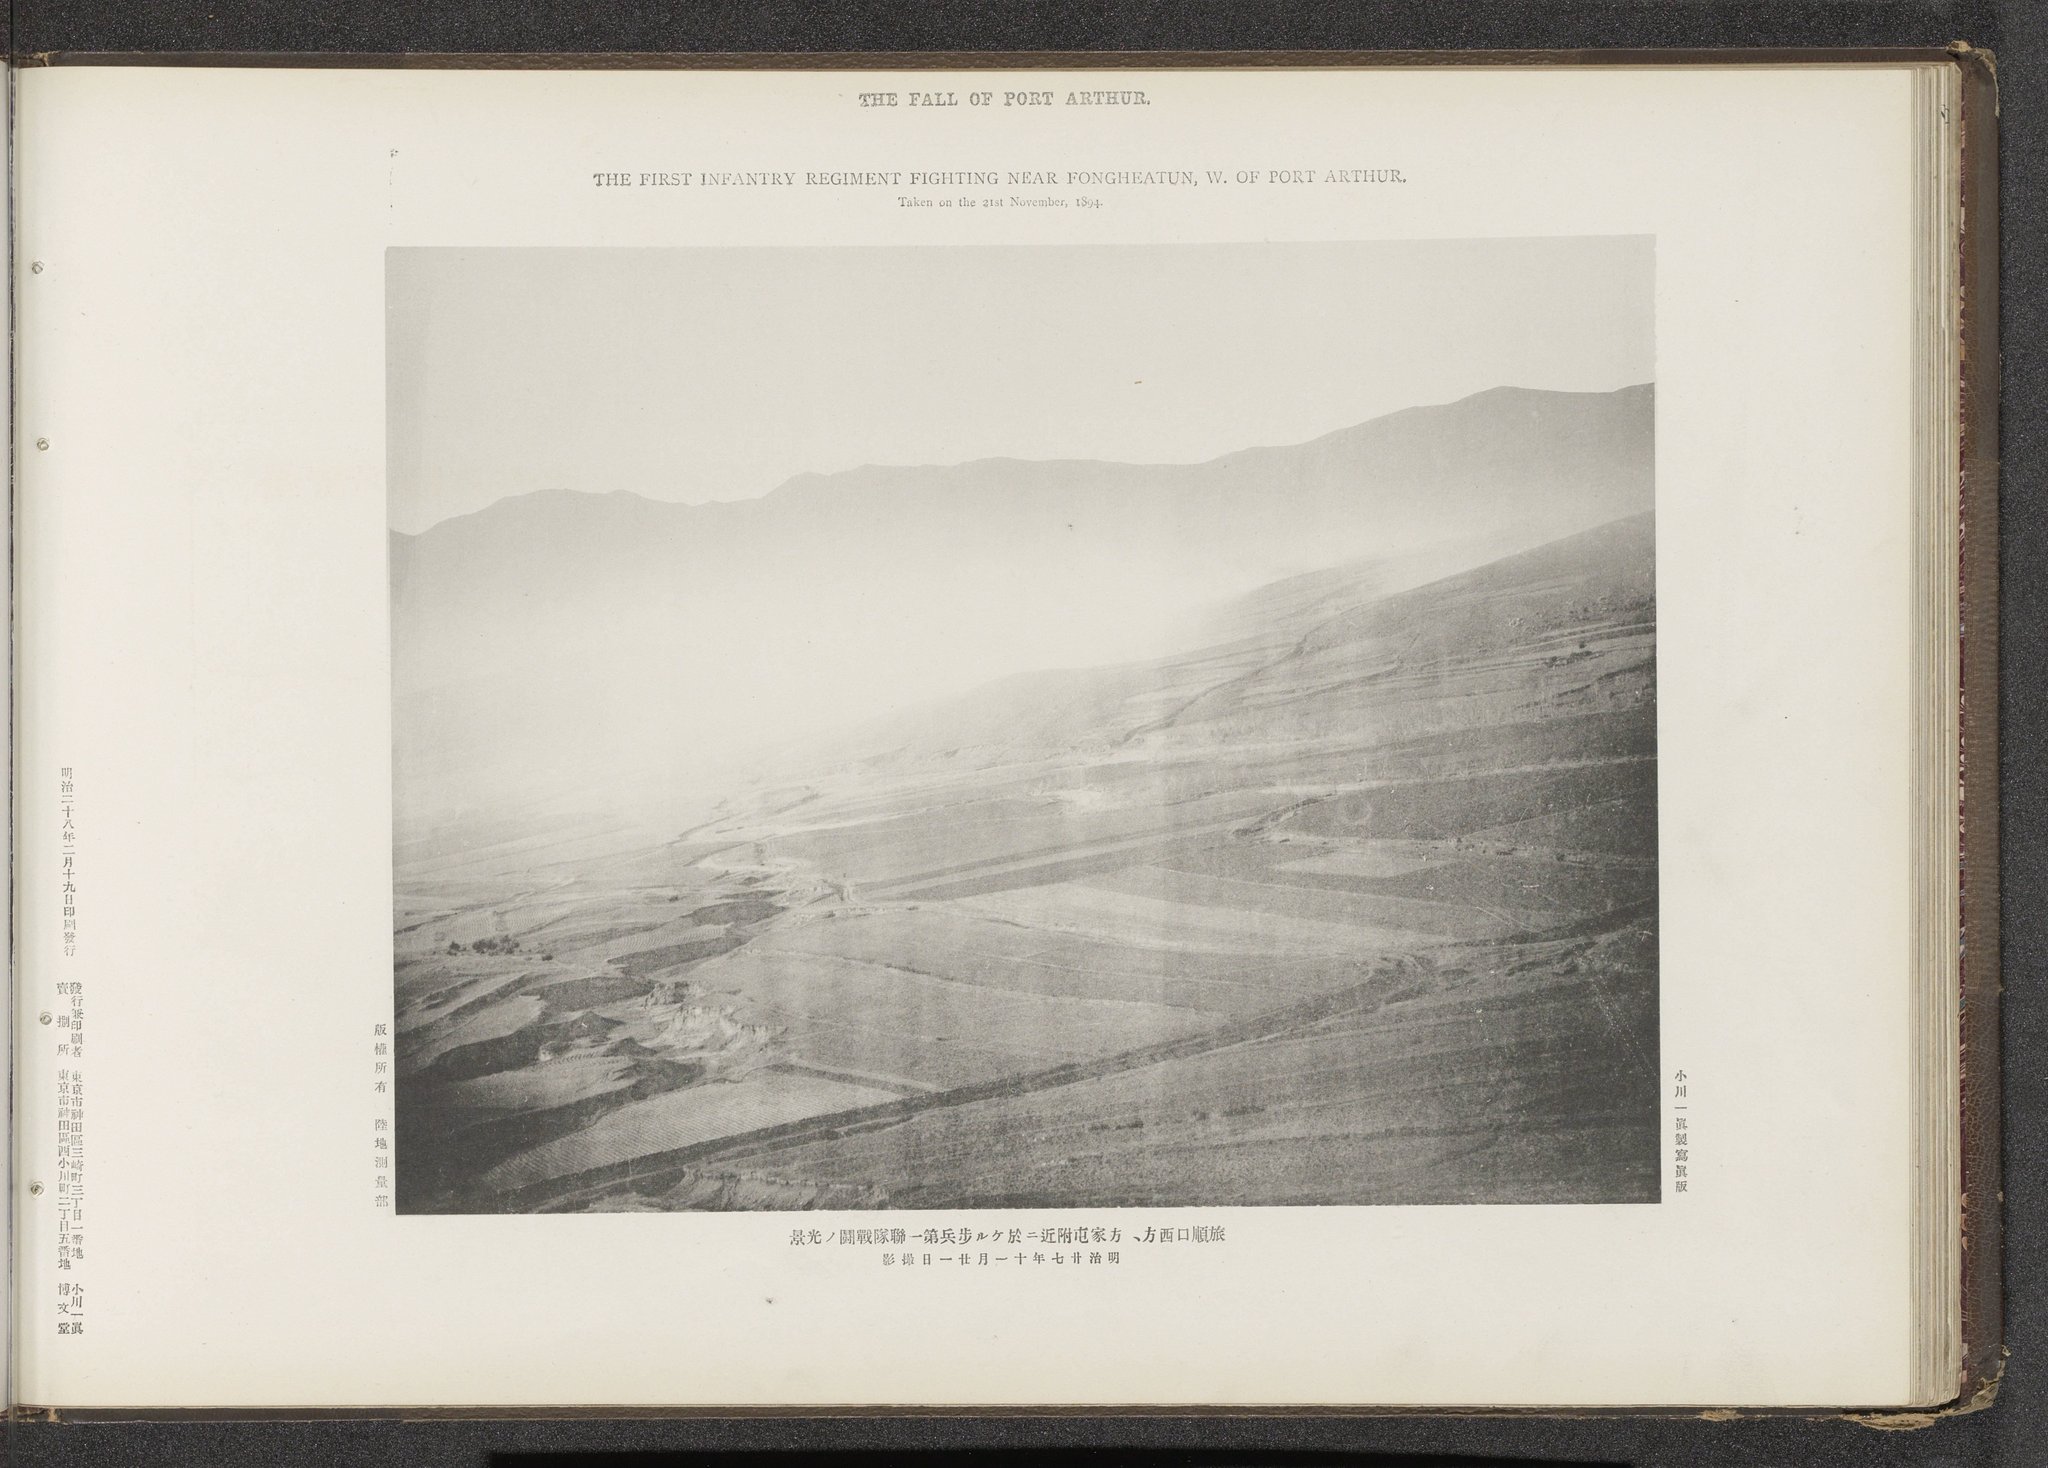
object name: photomechanical print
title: The first infantry fighting near Fongheatun, W. of Port Arthur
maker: kazumasa ogawa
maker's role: auteur, fotograaf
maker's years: 1860-1929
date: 1894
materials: paper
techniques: photograph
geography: japan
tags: army 'en route'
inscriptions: inscription: ‘The fall of Port Arthur.’